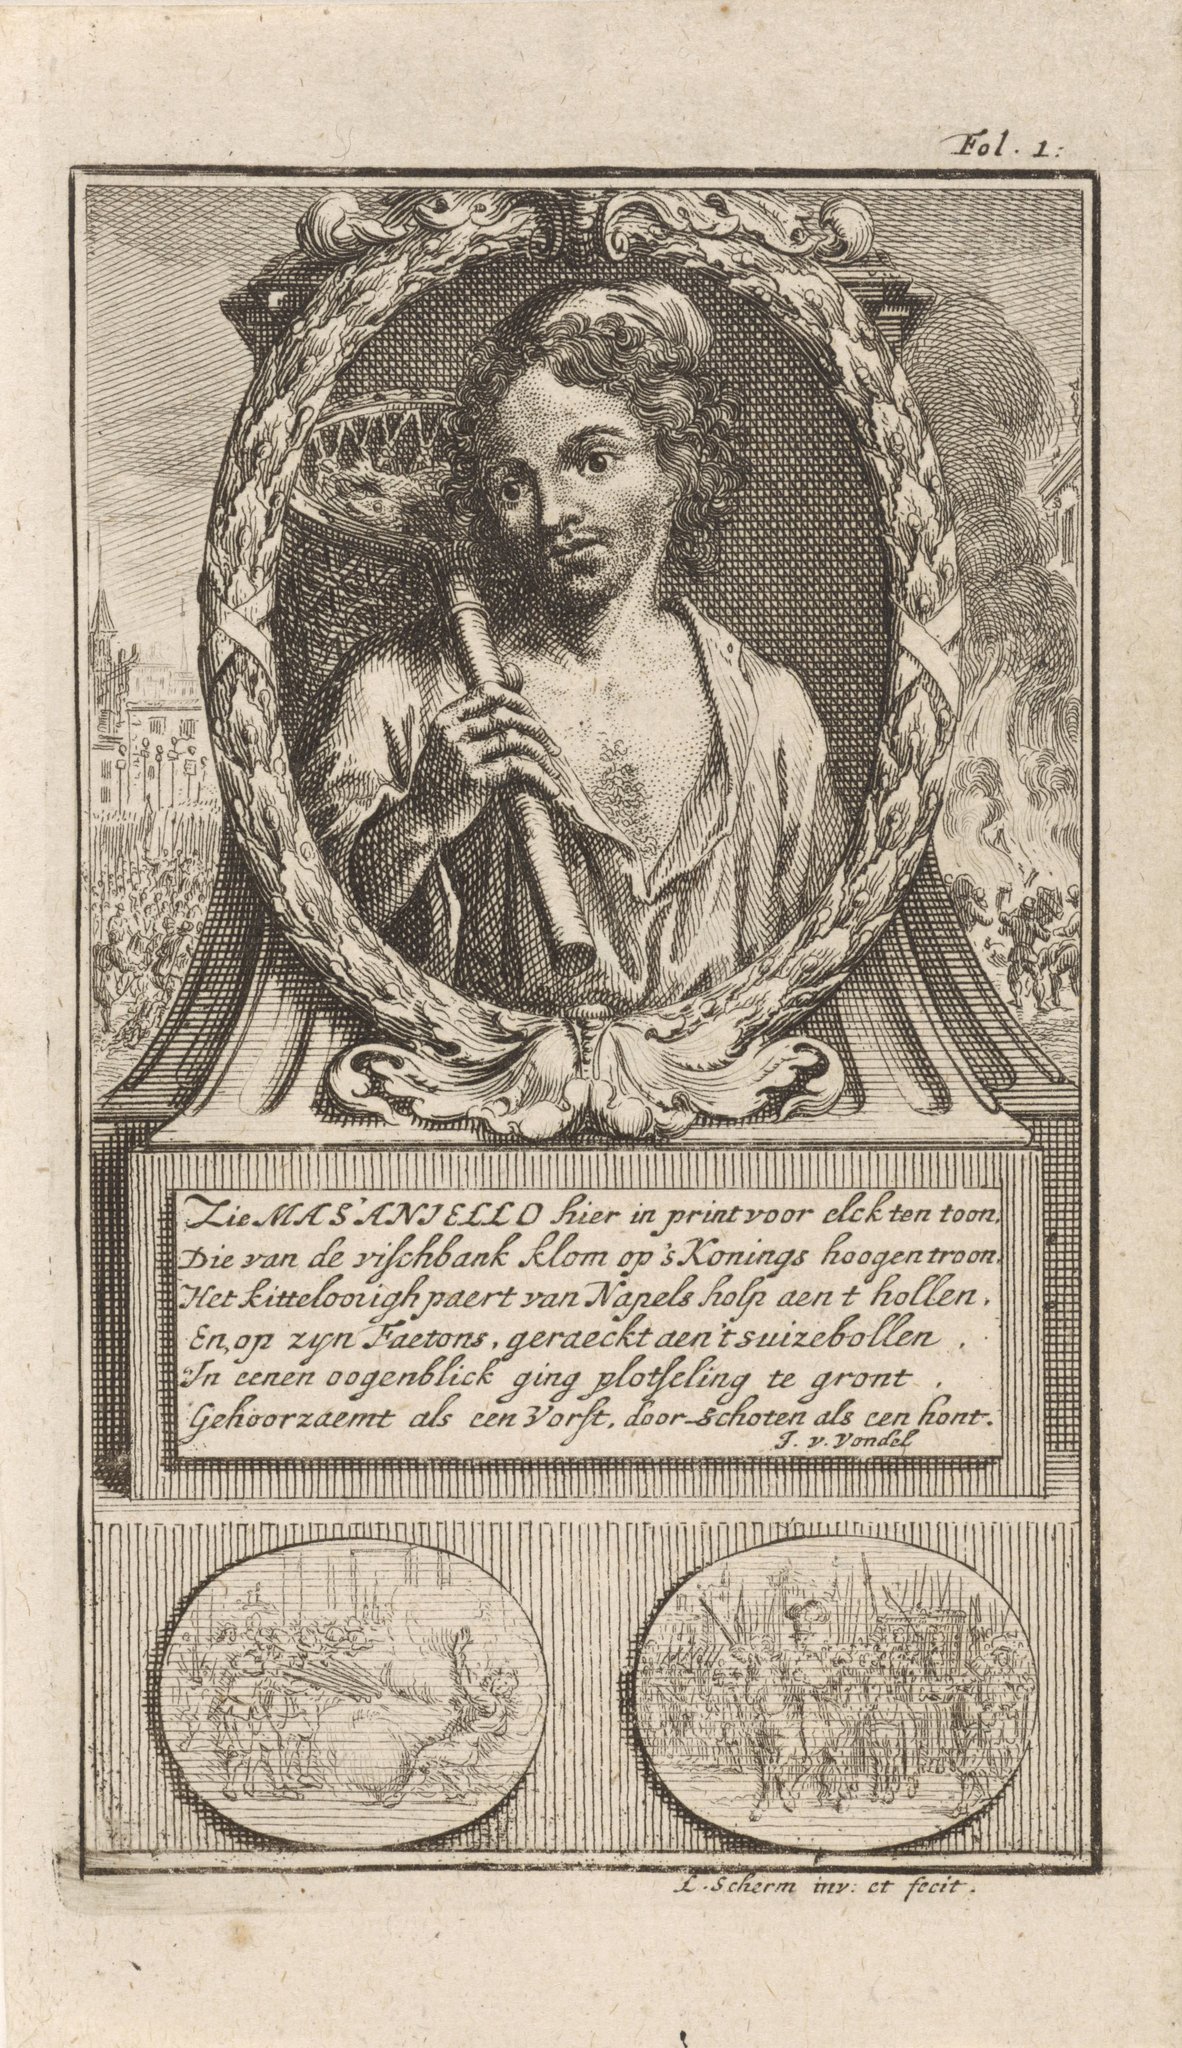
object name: book illustration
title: Masaniello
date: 1669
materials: paper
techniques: etching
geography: amsterdam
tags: naples, honouring the artist with laurel wreath, battle, fisherman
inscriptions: collector's mark: Lugt 2228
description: Portret van de opstandeling Masaniello. In zijn rechterhand houdt hij een gevuld visnet als verwijzing naar zijn oorspronkelijke beroep. Rond zijn portret een laurierkrans. Daaronder een zesregelig lofdicht in het Nederlands. In de verte en in twee medaillons onder het portret zijn vechtscènes te zien.